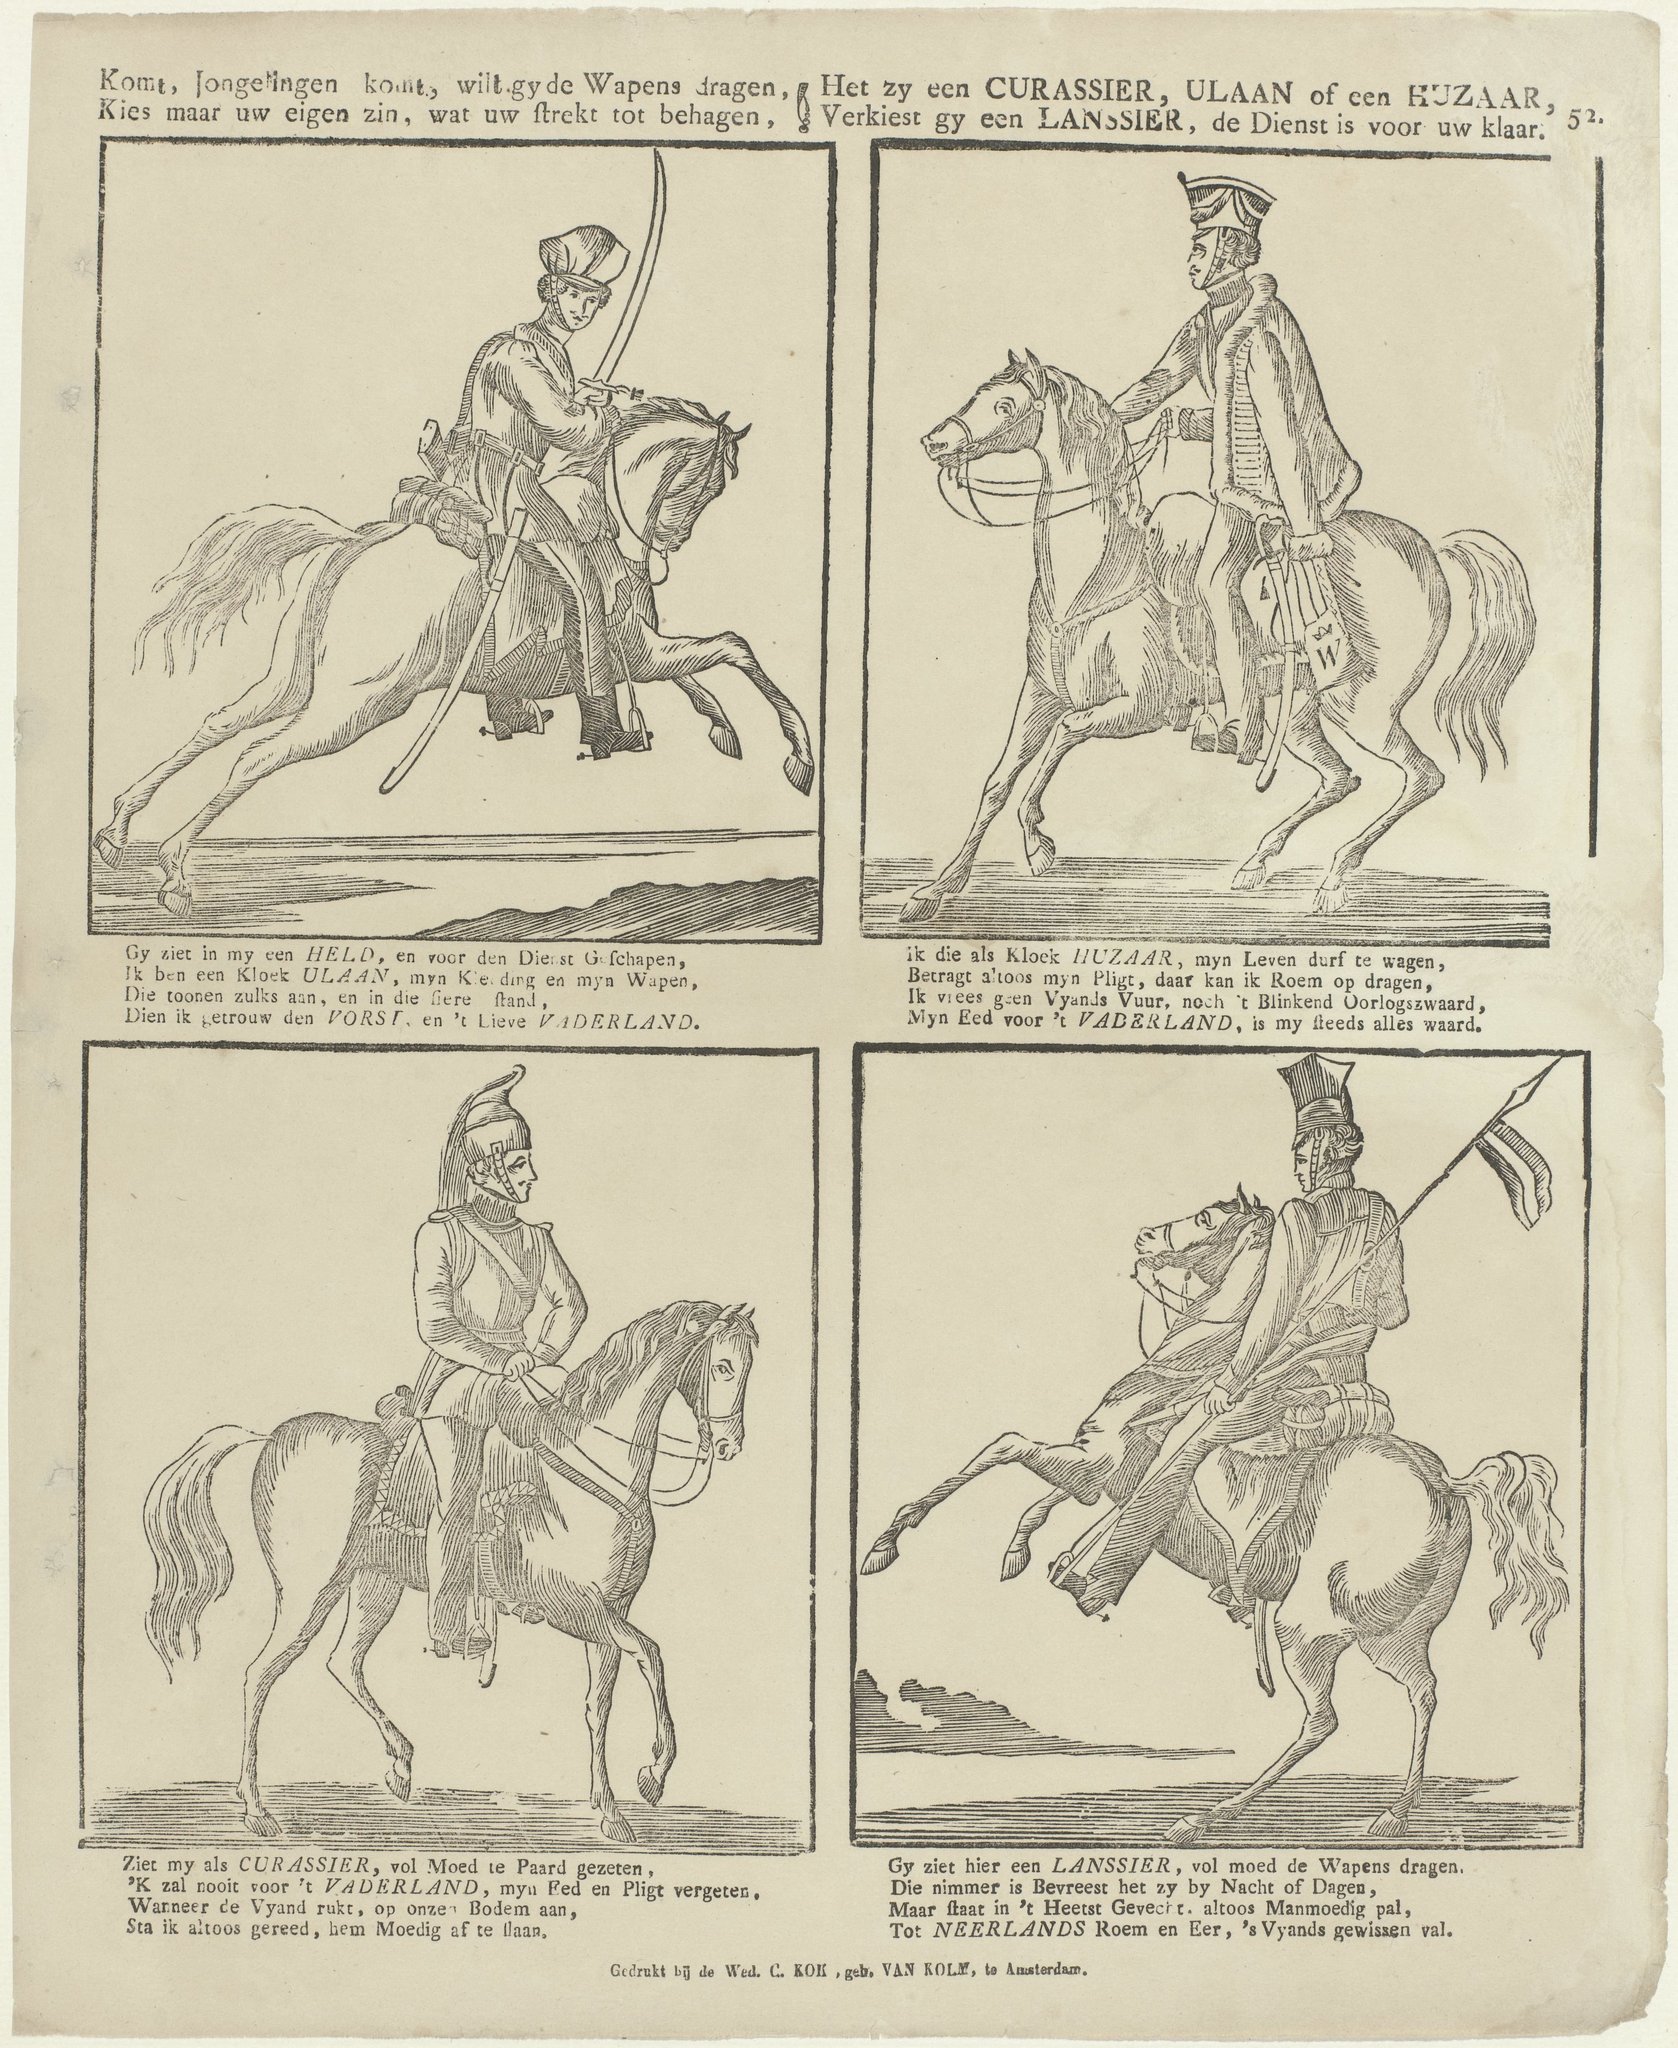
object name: print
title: Komt, jongelingen komt, wilt gy de wapens dragen, / Kies maar uw eigen zin, wat uw strekt tot behagen, / Het zy een curassier, ulaan of een huzaar, / Verkiest gy een lanssier, de dienst is voor uw klaar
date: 1842-1866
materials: paper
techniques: letterpress printing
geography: amsterdam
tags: warfare; military affairs (+ cavalry, horsemen), the soldier; the soldier's life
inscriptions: collector's mark: Lugt 2760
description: Blad met 4 voorstellingen van militairen te paard. Onder elke afbeelding een vierregelig vers. Genummerd rechtsboven: 52.